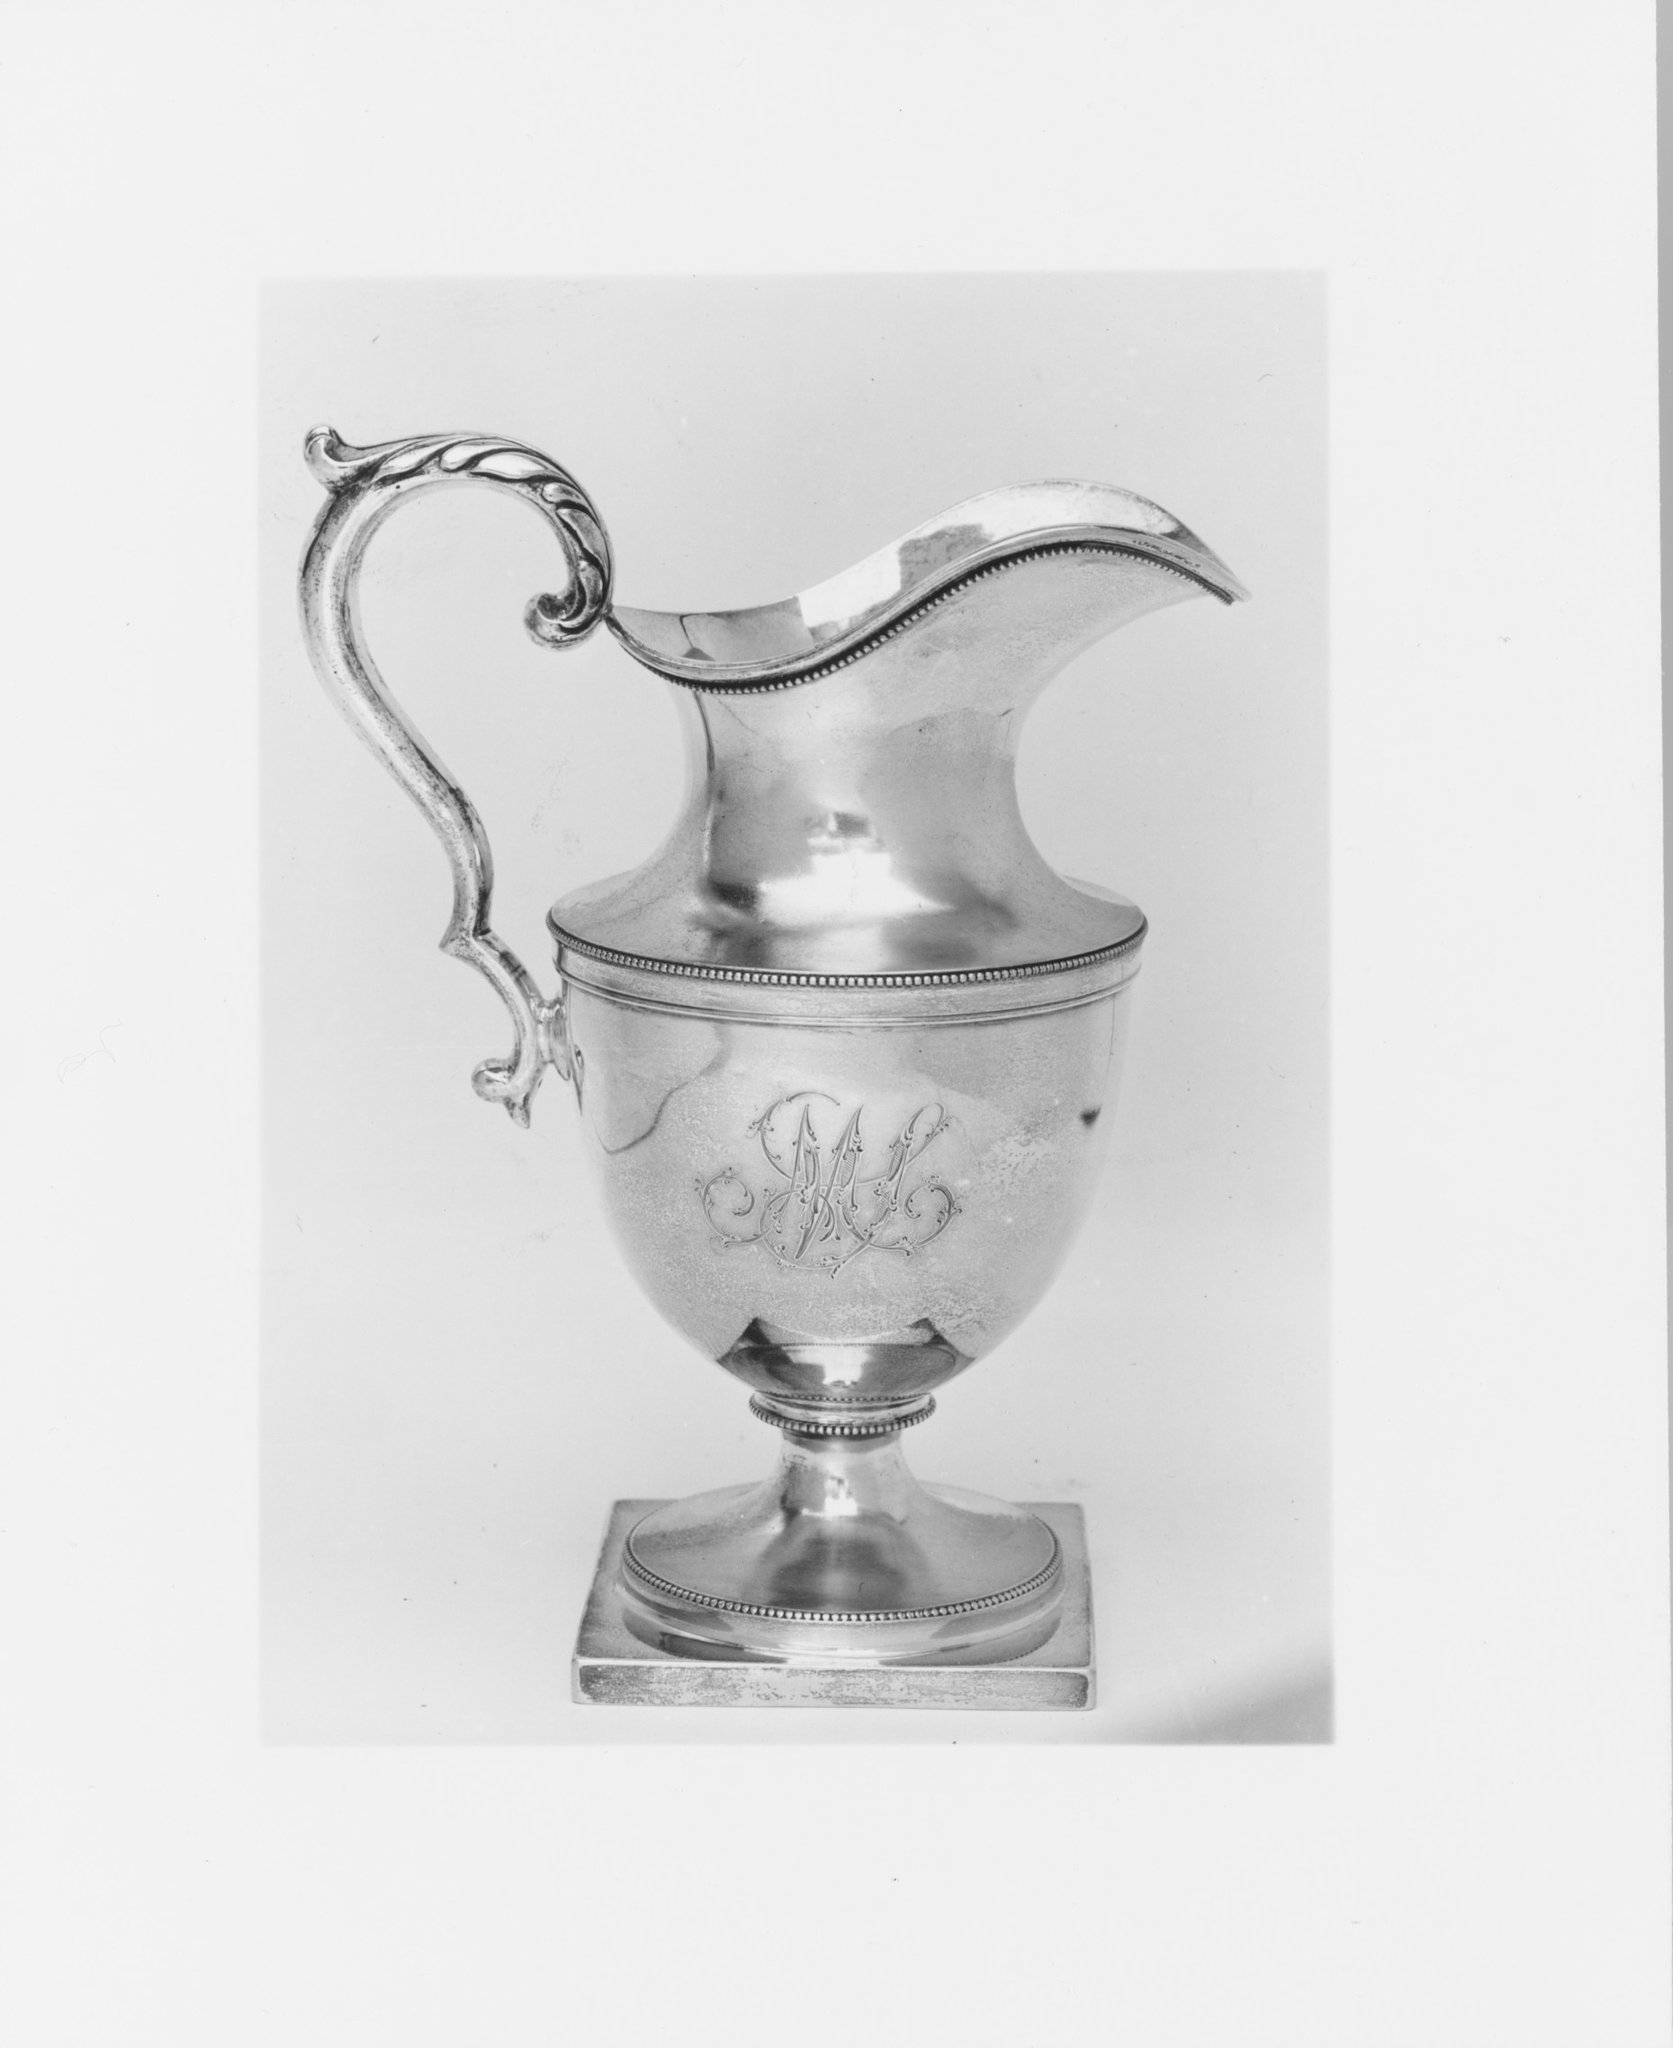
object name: cream pot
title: Creamer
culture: american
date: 1810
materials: silver